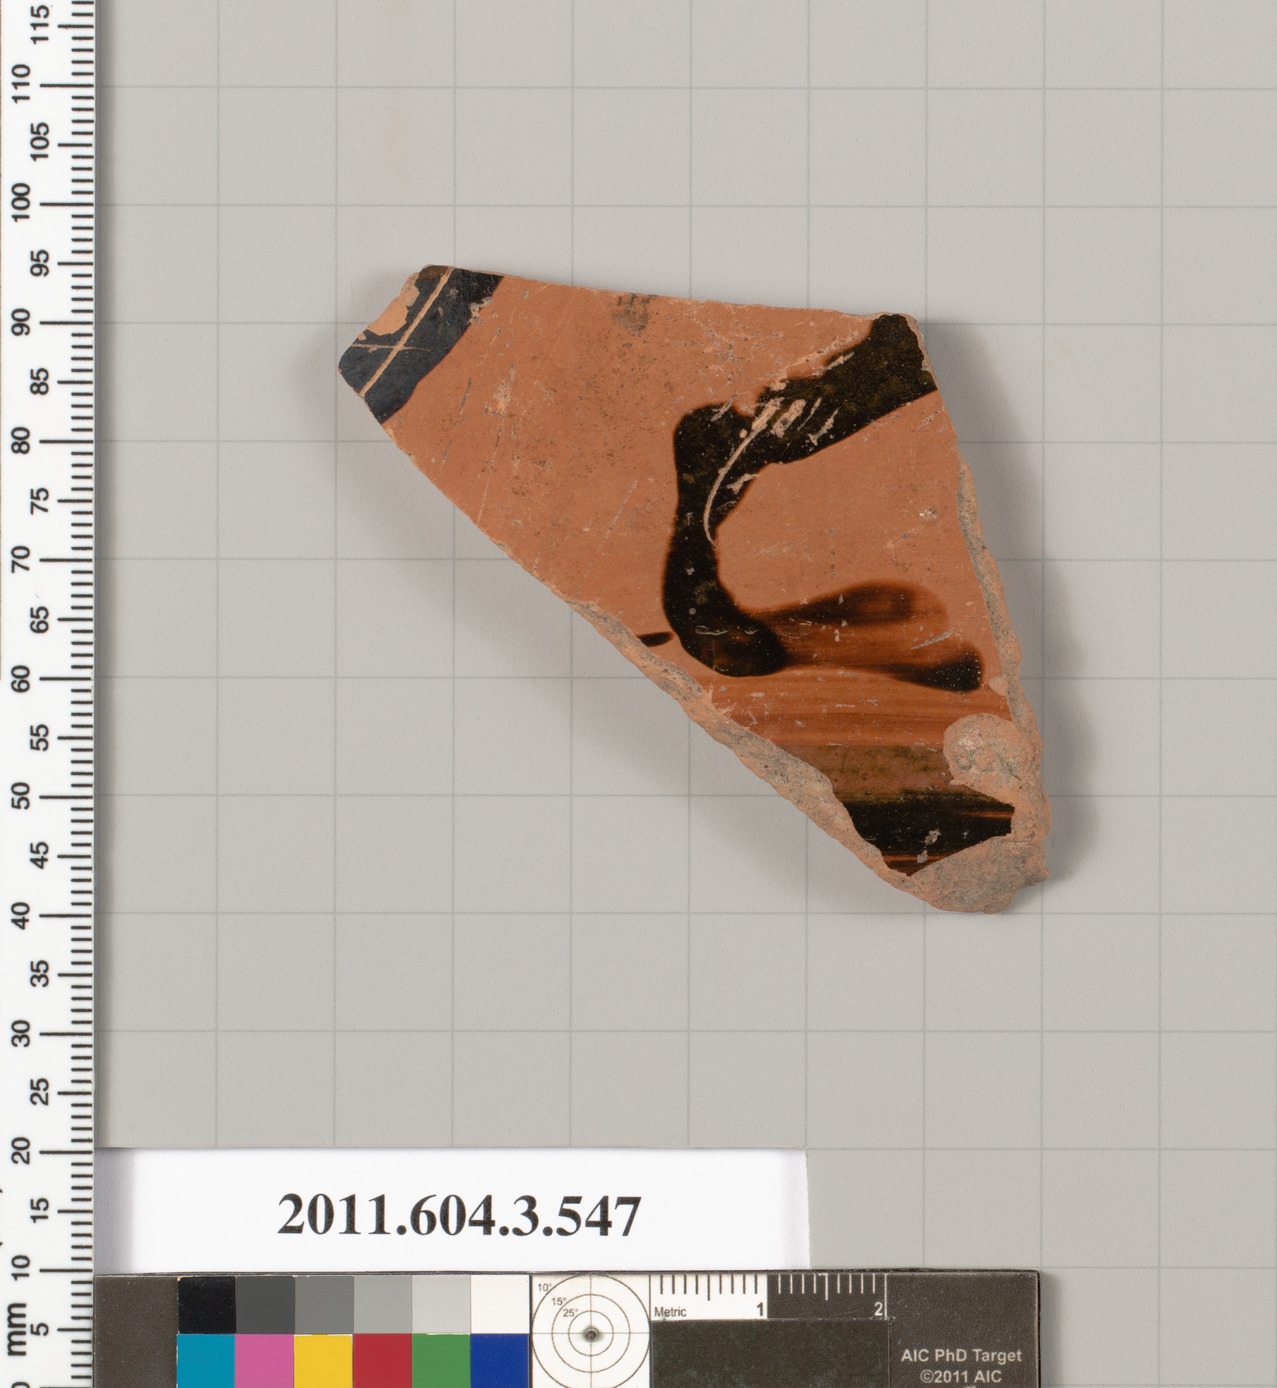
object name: column krater fragment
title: Terracotta fragment of a column-krater (bowl for mixing wine and water)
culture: greek, attic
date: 534-468 BCE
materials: terracotta